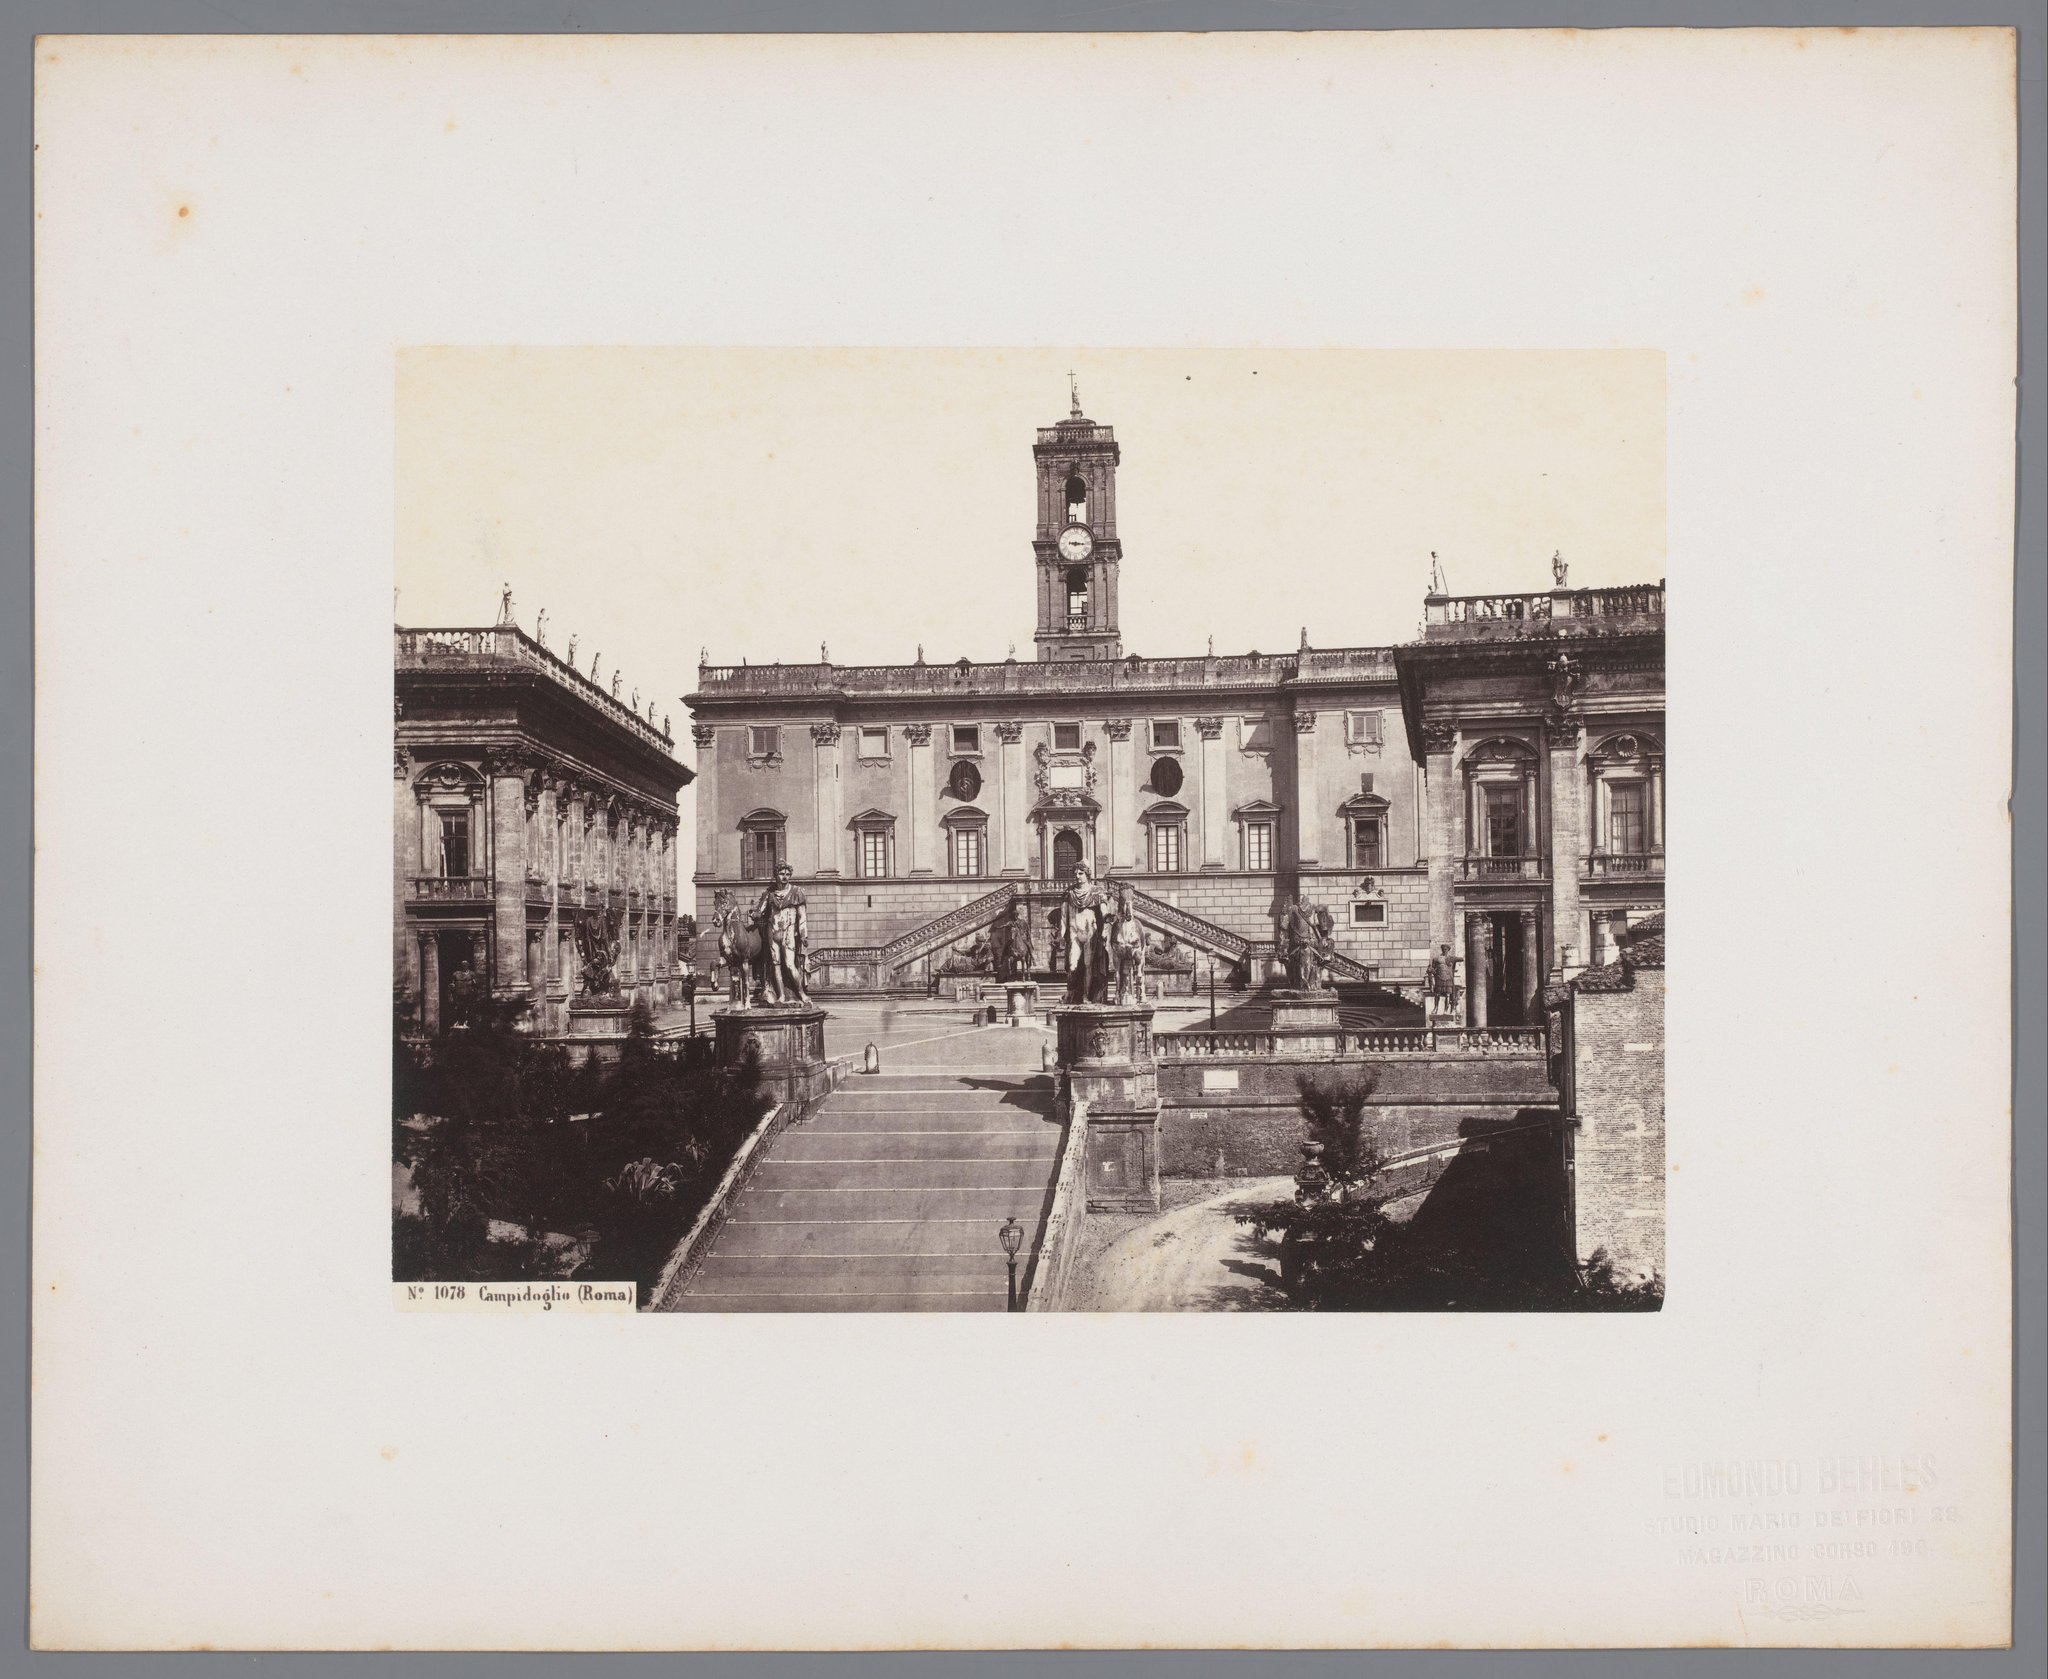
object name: photograph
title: Campidoglio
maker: edmondo behles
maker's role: fotograaf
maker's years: 1841-1921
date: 1859-1890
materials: cardboard, paper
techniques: albumen print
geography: rome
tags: square, place, circus, etc., equestrian statue, exterior ~ representation of a building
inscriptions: number: ‘No. 1078’, address: ‘EDMONDO BEHLES/ STUDIO MARIO DE'FIORI 23./ MAGAZZINO CORSO 196./ ROMA’, number: ‘26’